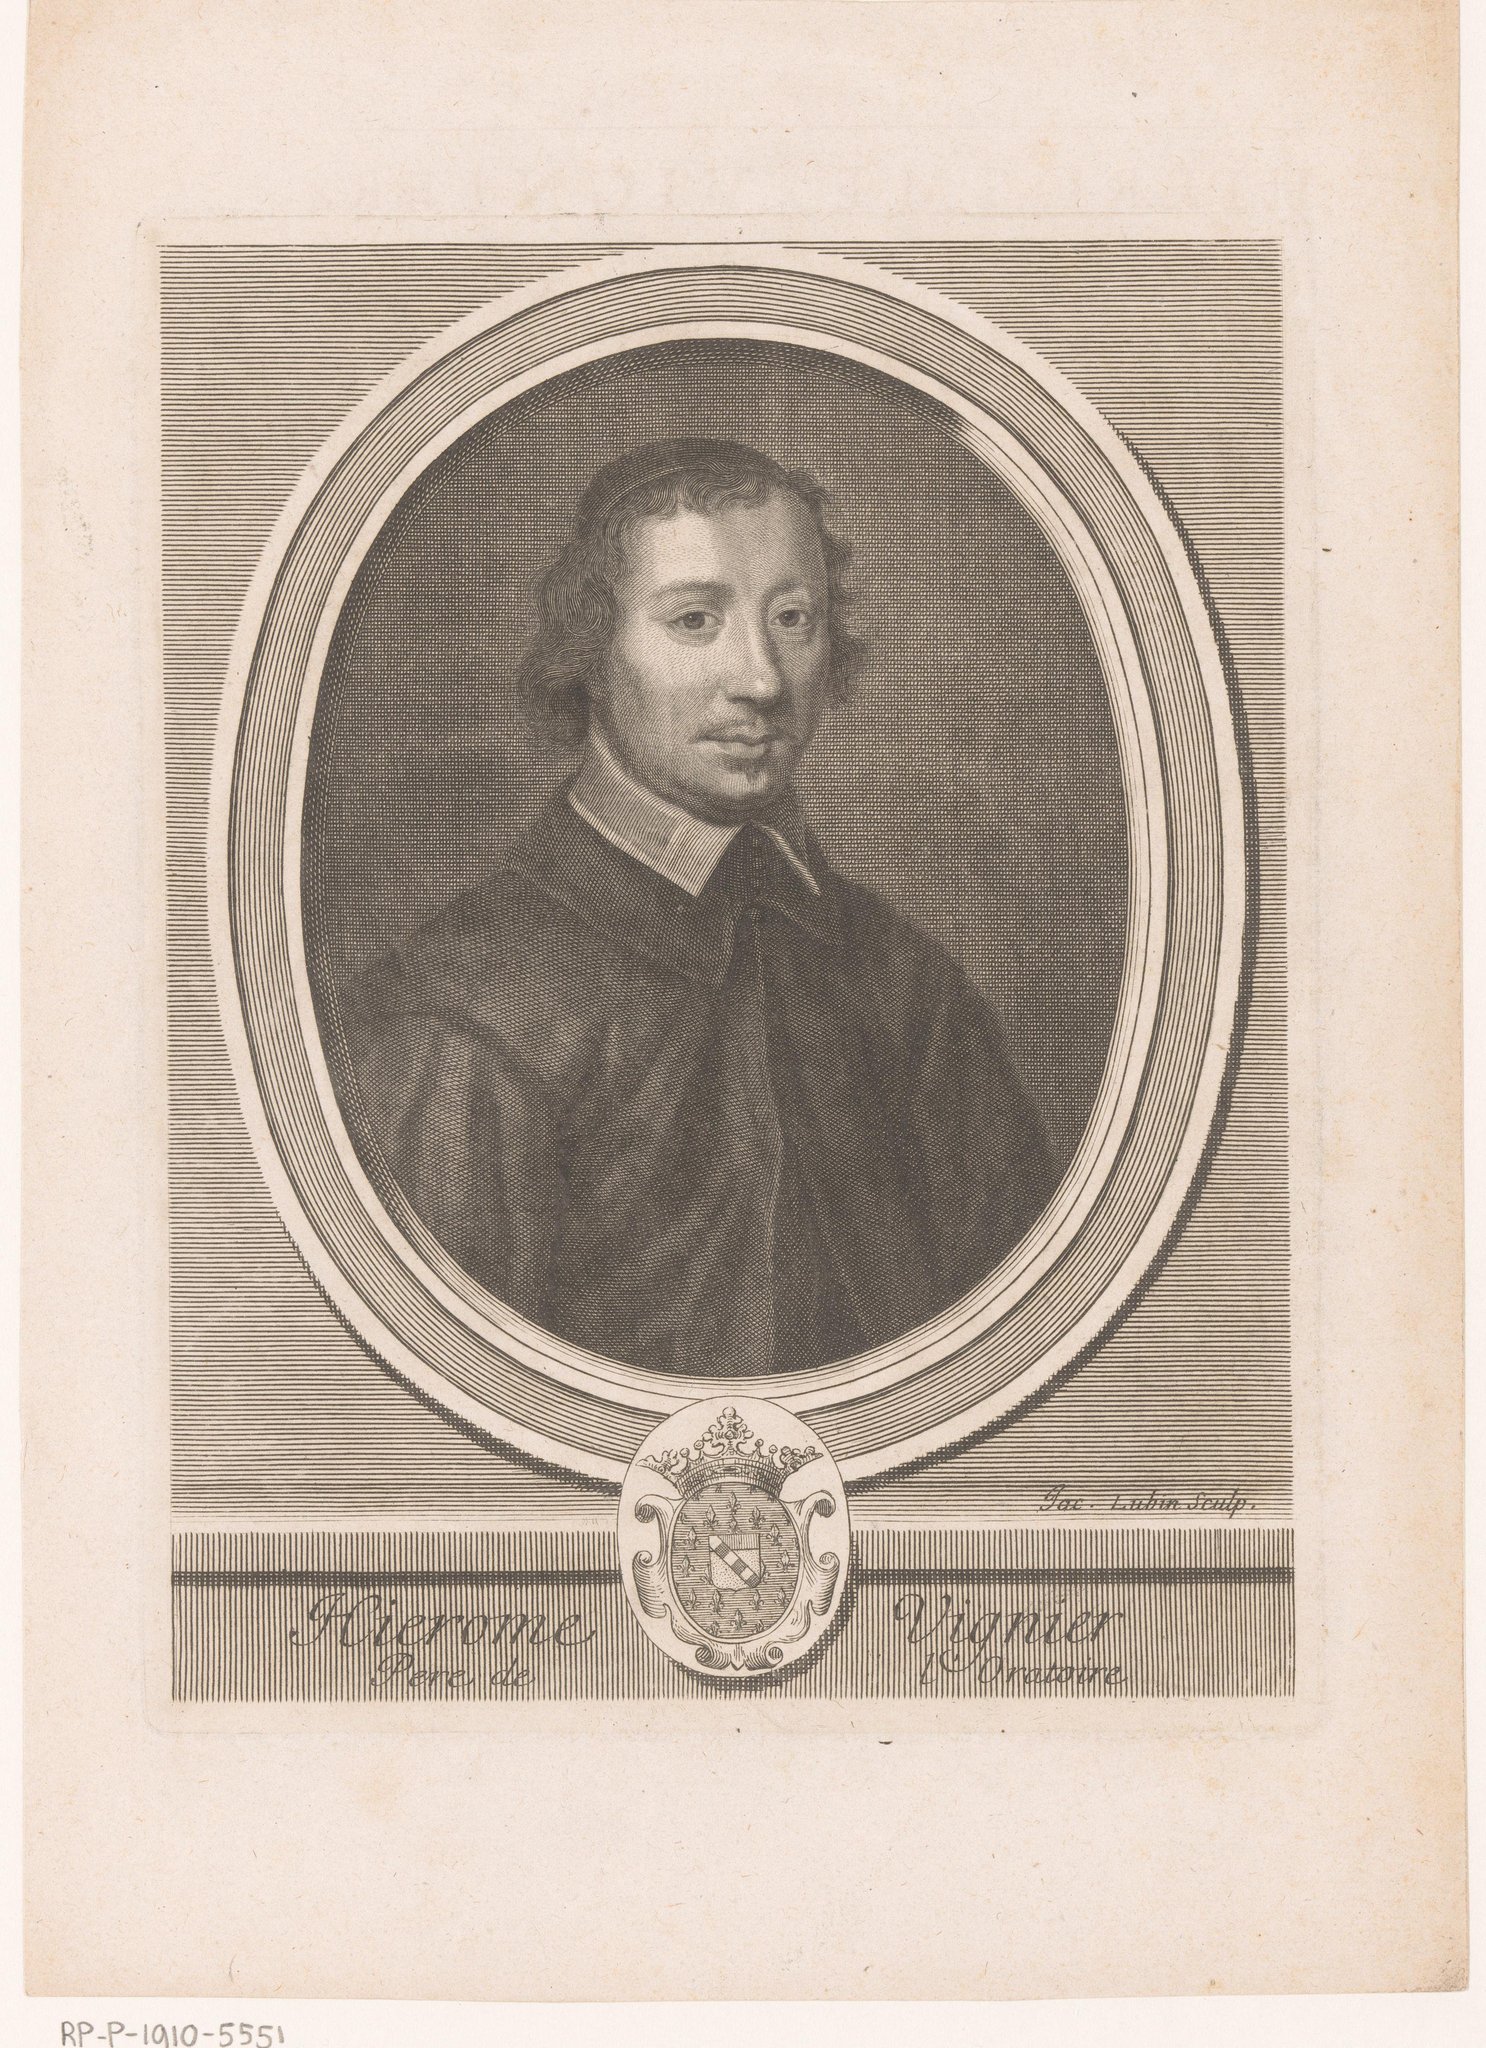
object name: print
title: Portret van Jérôme Vignier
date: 1696-1700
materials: paper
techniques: engraving, etching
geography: paris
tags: paris, priest (roman catholic), historical persons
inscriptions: collector's mark: Lugt 2228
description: Prent uit: Perrault, Charles. Les hommes illustres qui ont paru en France pendant ce siècle. Parijs: Antoine Dezallier, 1696-1700.